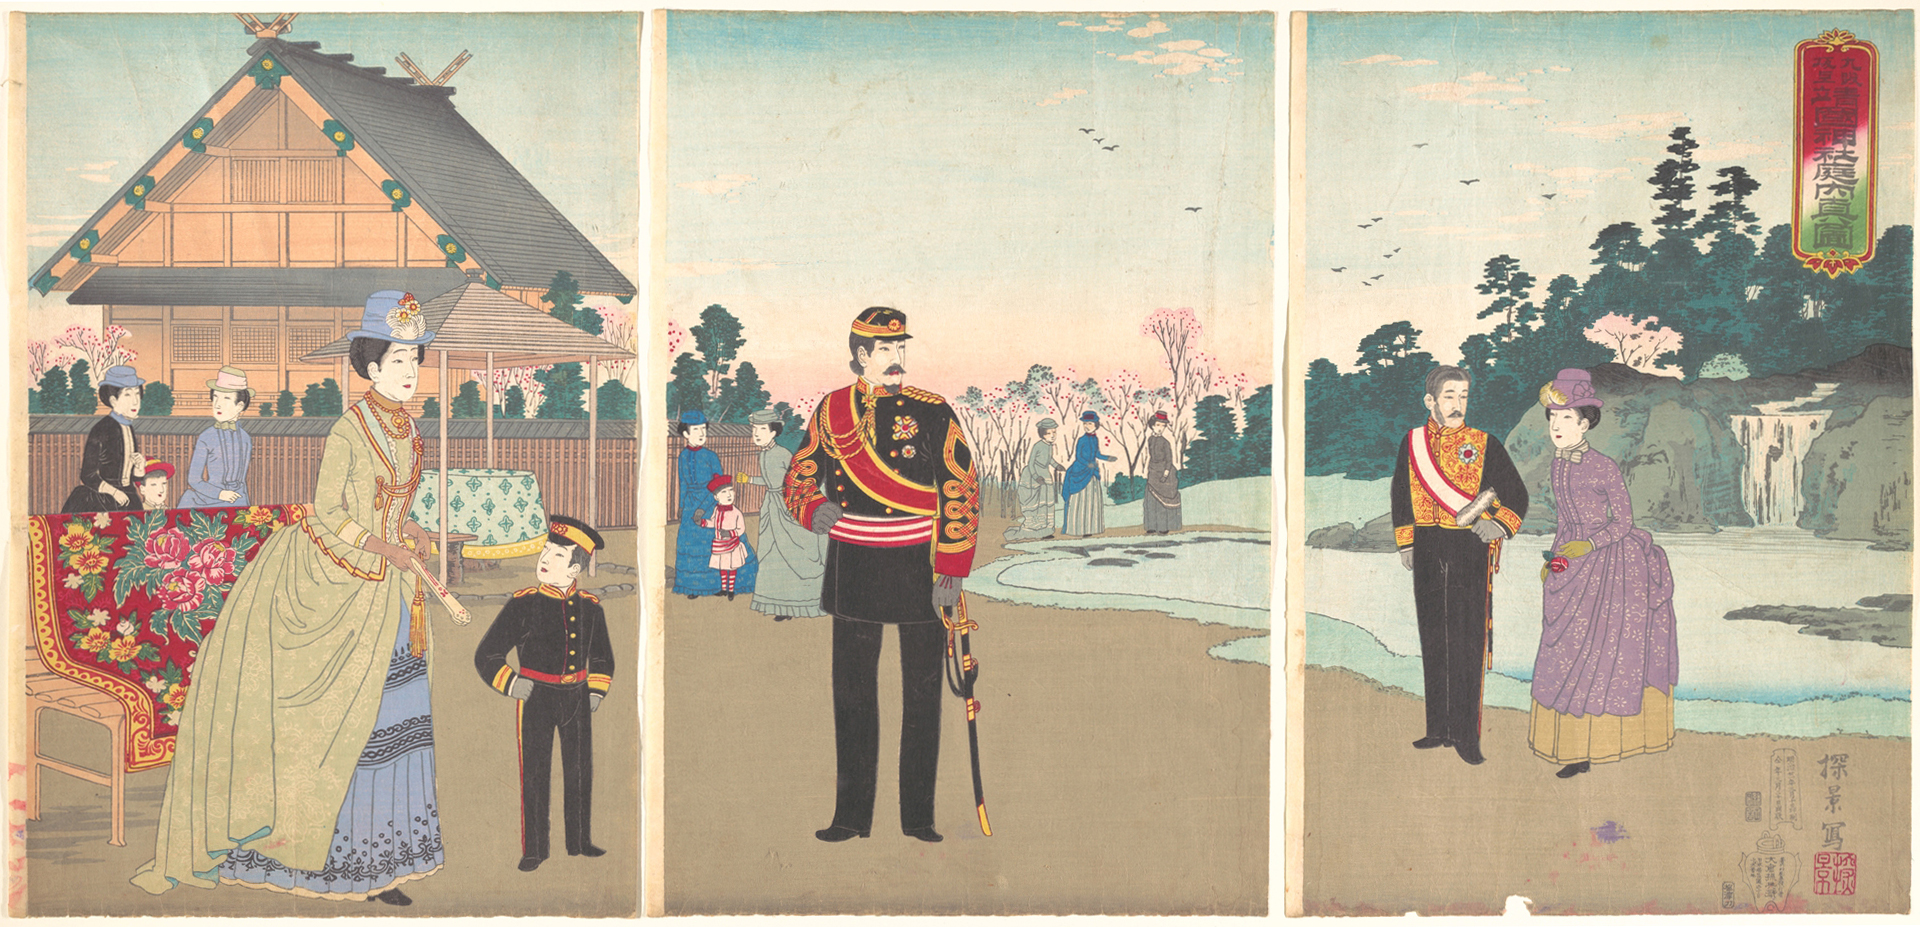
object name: print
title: True View of the Courtyard of Yasukuni Shrine at the Top of Kudanzaka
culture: japanese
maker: inoue yasuji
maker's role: artist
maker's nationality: japanese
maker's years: 1864-1889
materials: ink, paper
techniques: nishiki e, woodblock print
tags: courtyards,children,men,women